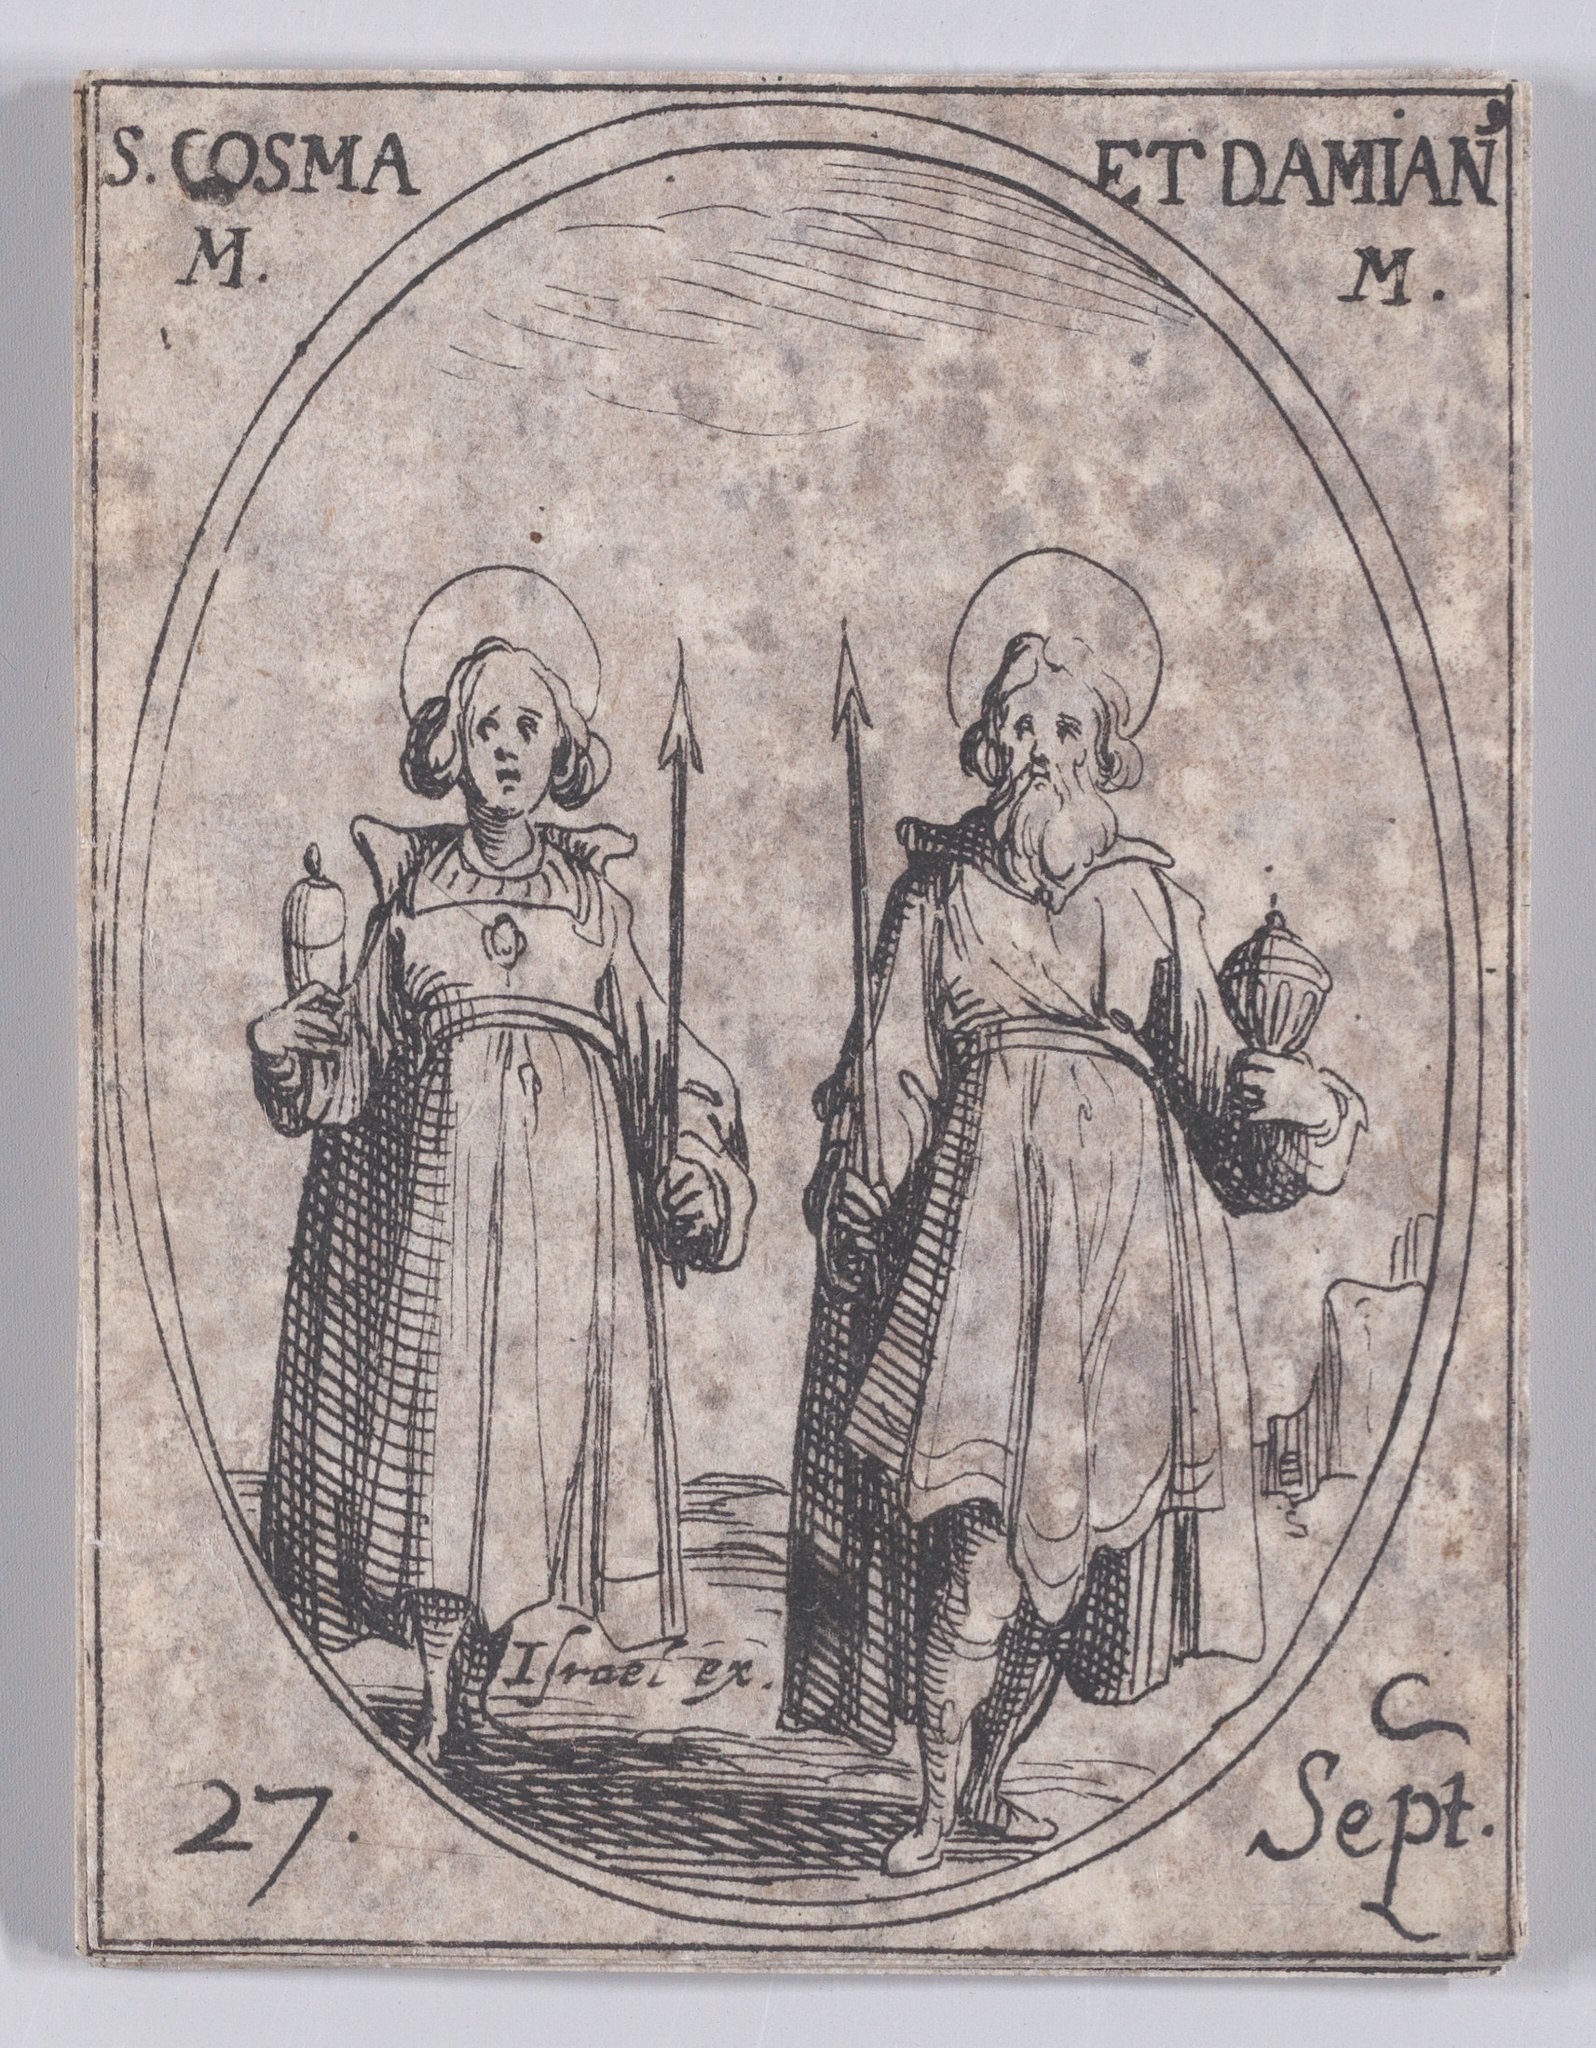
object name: print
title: S. Cosme et S. Damien, martyrs (St. Cosmas and St. Damian, Martyrs), September 27th, from "Les Images De Tous Les Saincts et Saintes de L'Année" (Images of All of the Saints and Religious Events of the Year)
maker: jacques callot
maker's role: artist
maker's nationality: french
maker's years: 1592-1635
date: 1636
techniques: etching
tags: men,women,saints